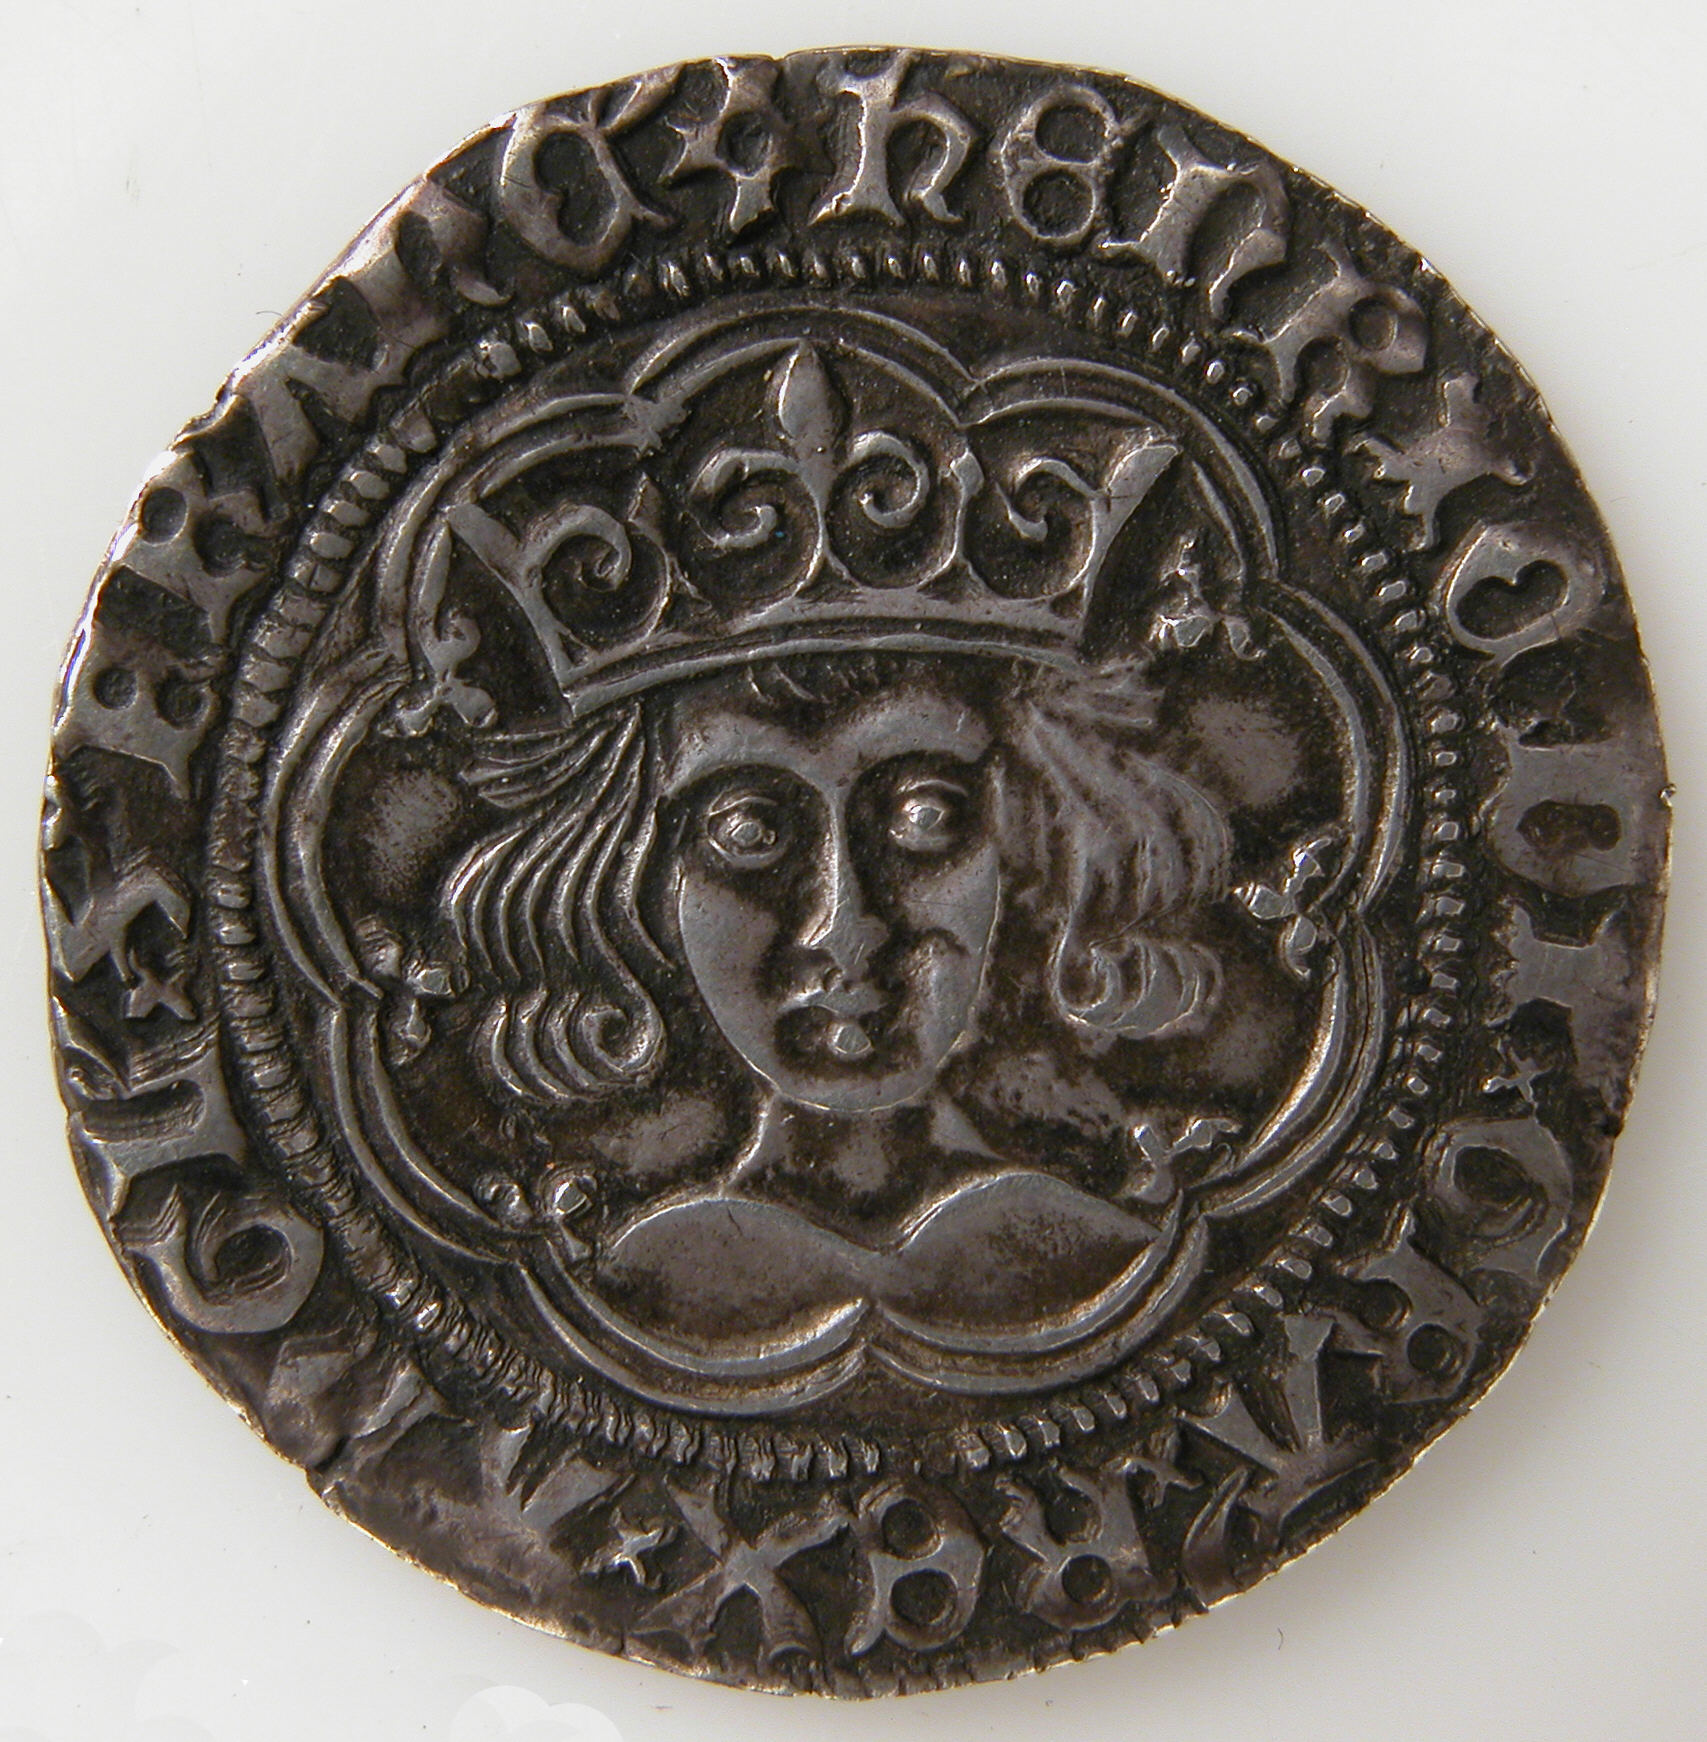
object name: coin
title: Groat of Henry VI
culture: british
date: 1422-1427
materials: silver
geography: england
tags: kings